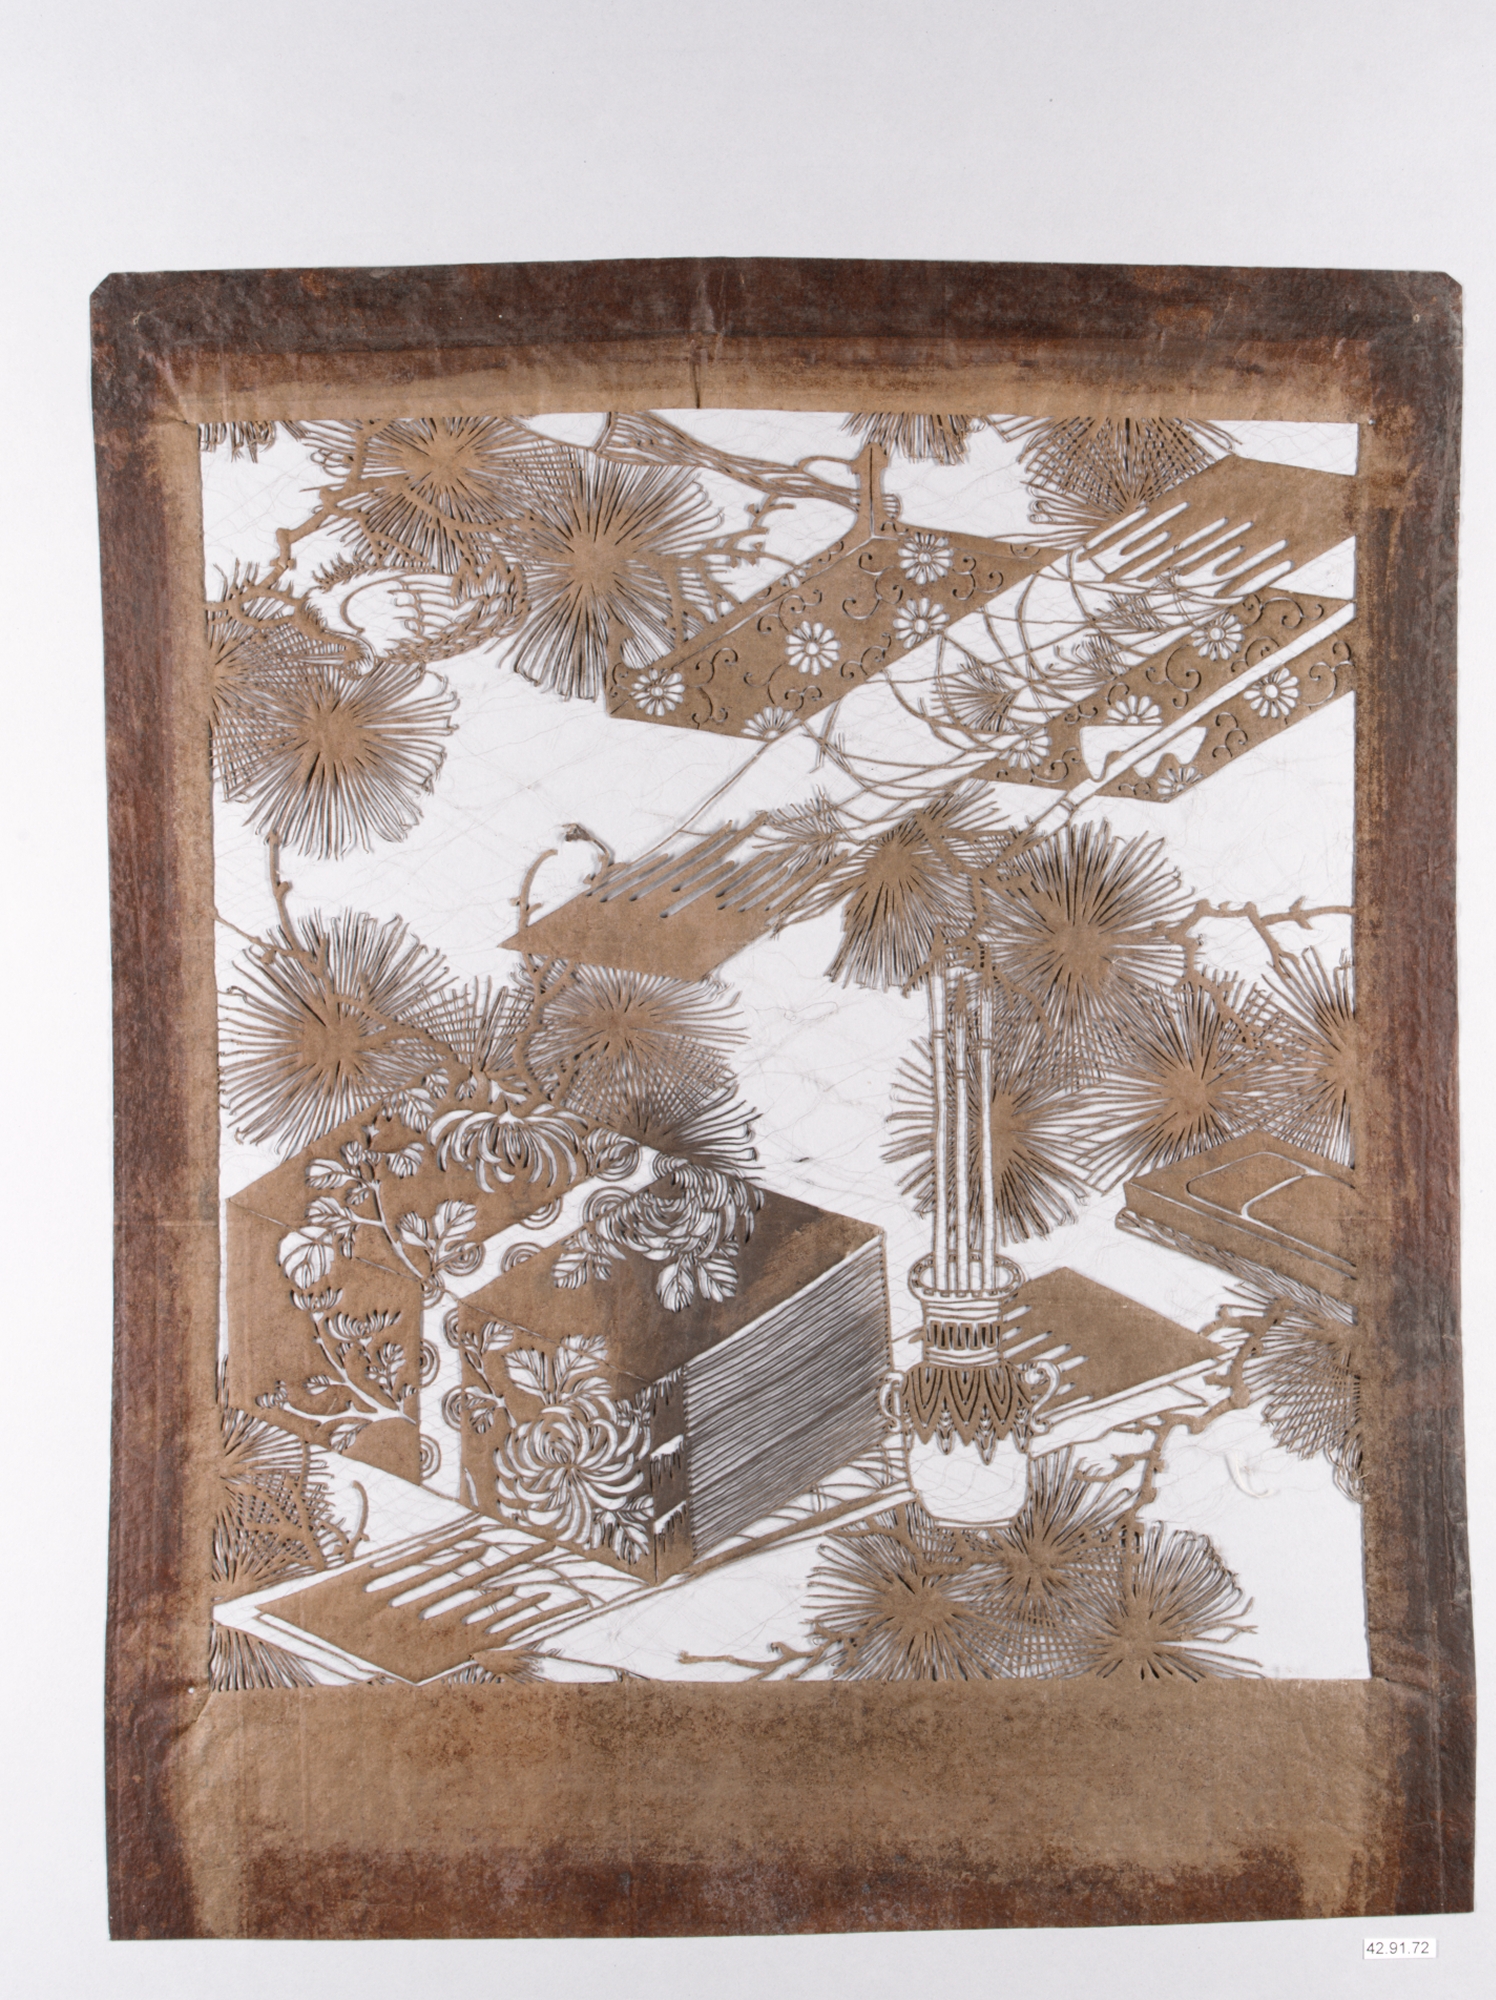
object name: stencil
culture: japanese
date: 1801-1900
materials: paper, silk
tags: books